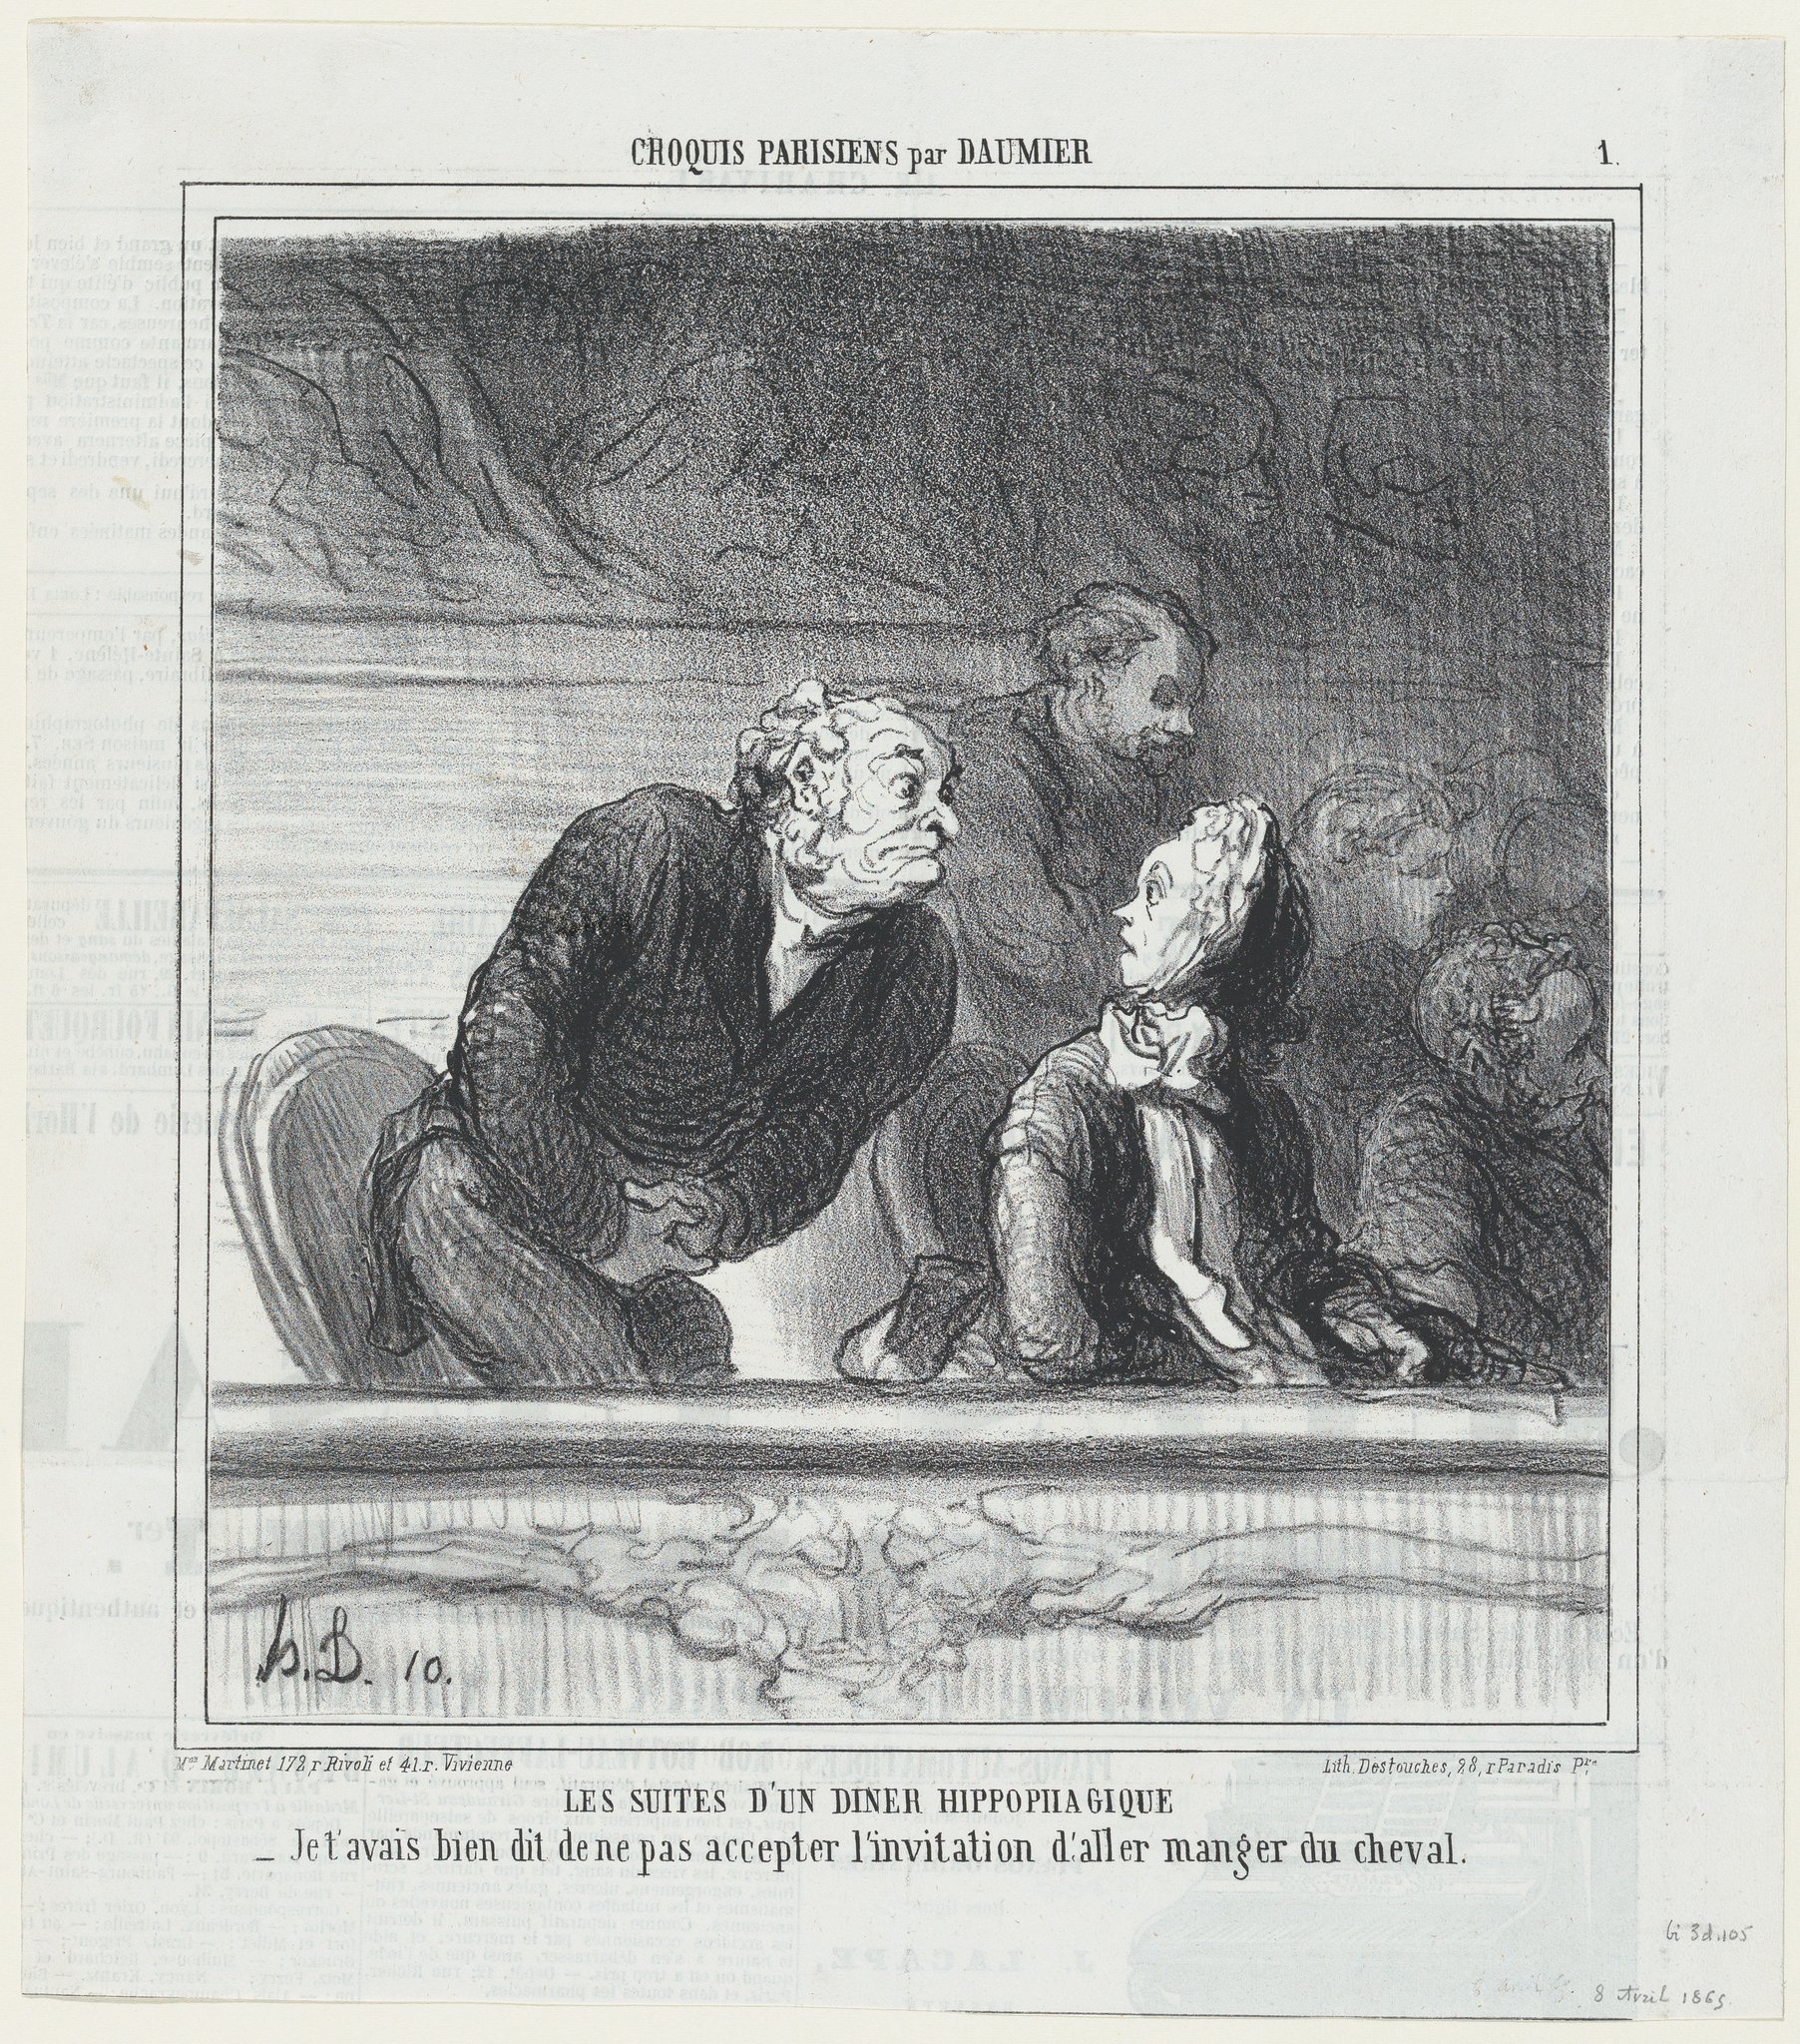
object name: print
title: Consequences of a horsemeat dinner, from 'Parisian sketches,' published in Le Charivari, April 8, 1865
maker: honoré daumier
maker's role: artist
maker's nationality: french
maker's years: 1808-1879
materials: paper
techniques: lithograph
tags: satire,men,women